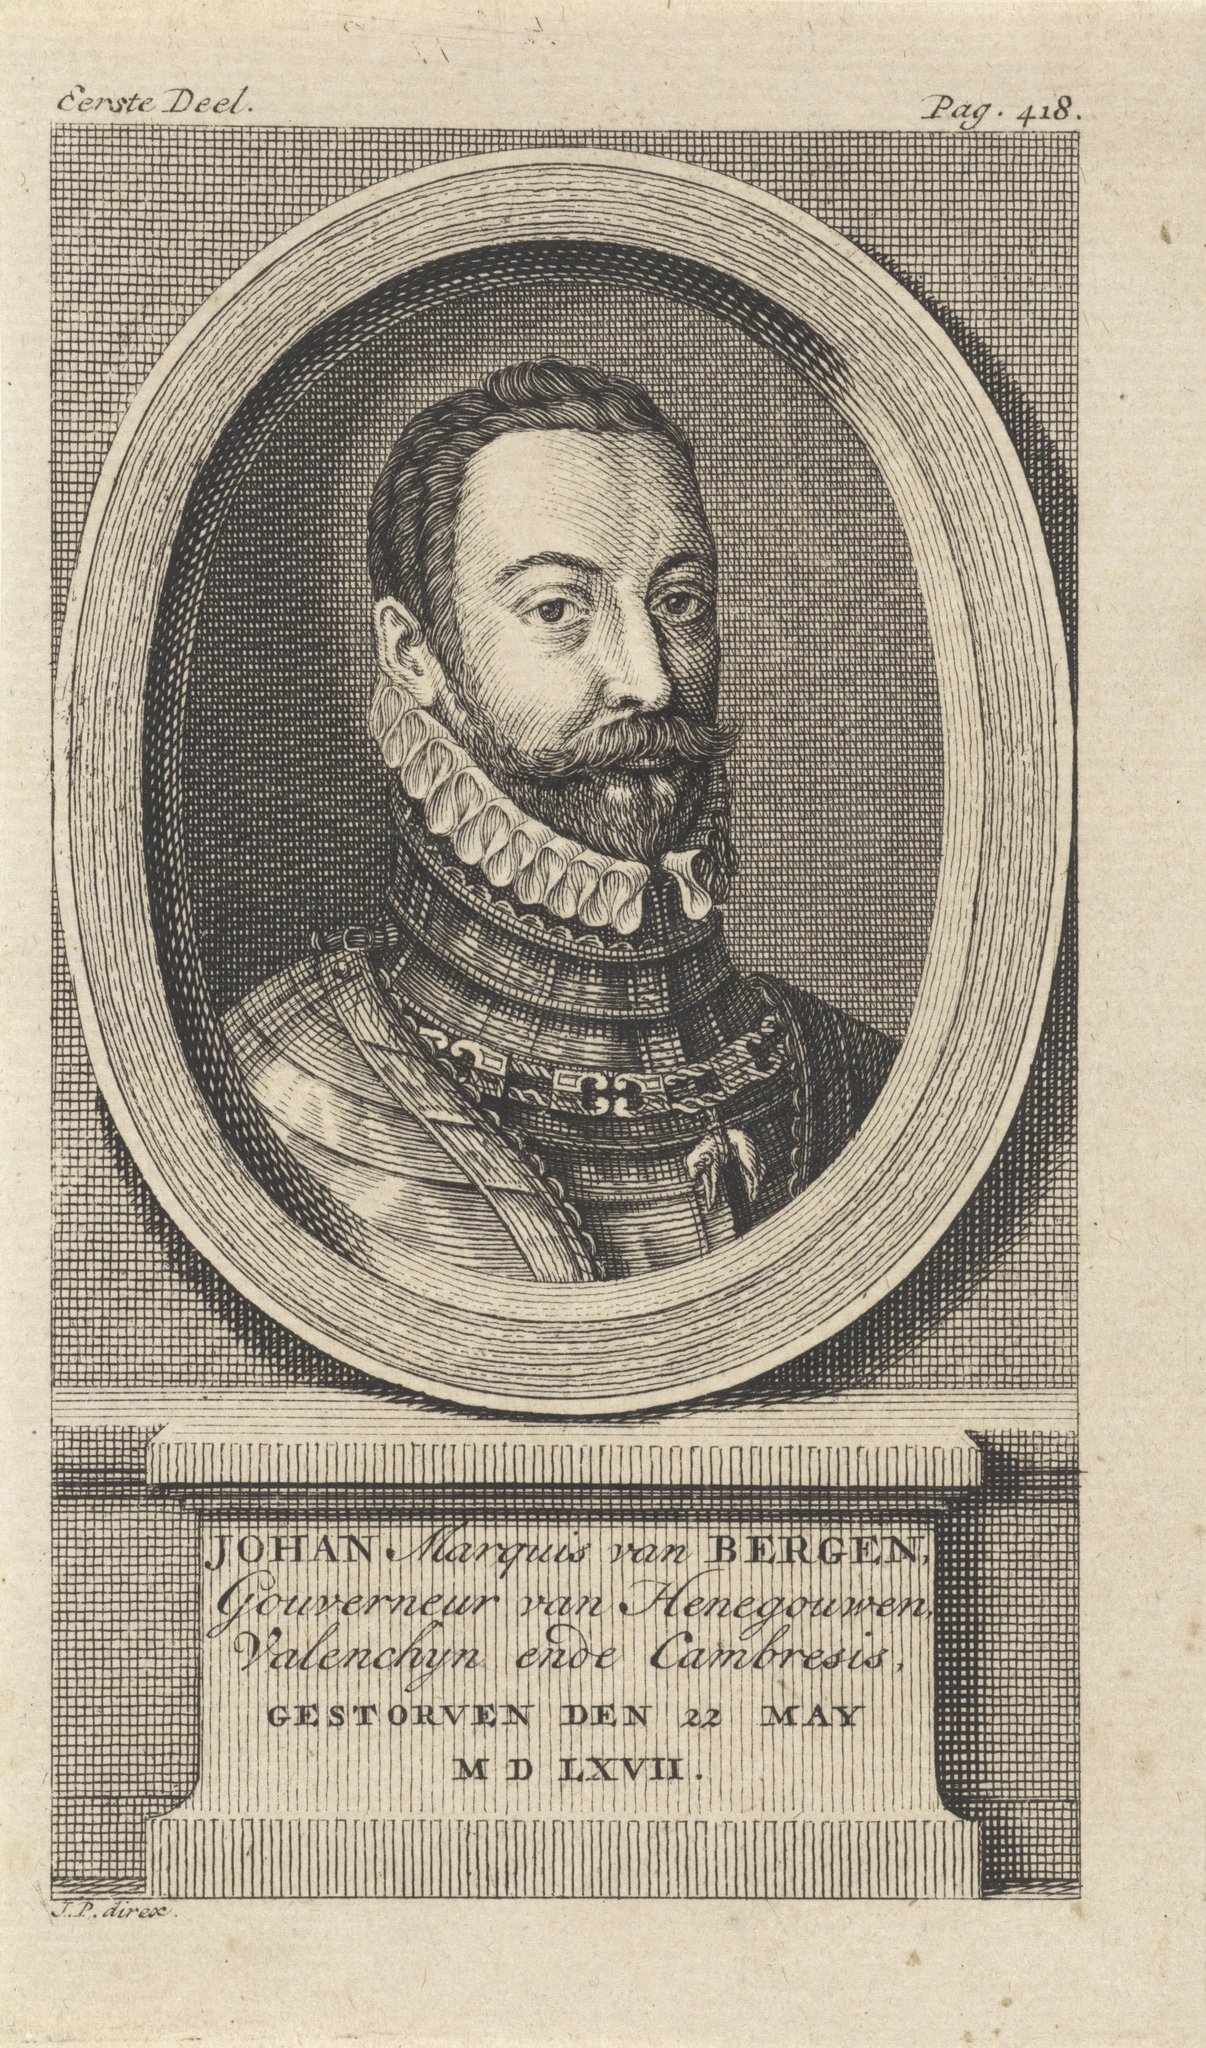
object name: print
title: Portret van Jan IV van Glymes, markies van Bergen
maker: jan punt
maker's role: draughtsman, print maker, publisher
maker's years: 1711-1779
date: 1748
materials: paper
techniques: engraving, etching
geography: northern netherlands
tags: bergen op zoom, armour, knighthood order of the golden fleece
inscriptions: collector's mark: Lugt 2228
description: Prent gebruikt als illustratie in: Meteren, Emanuel van. Historie van de oorlogen en geschiedenissen der Nederlanderen, en der zelver naburen: beginnende met den jare 1315, en eindigende met den jare 1611, deel I, p. 418. Gorinchem/Breda: Nicolaas Goetzee, Pieter Goetzee/Willem Goetzee, 1748.